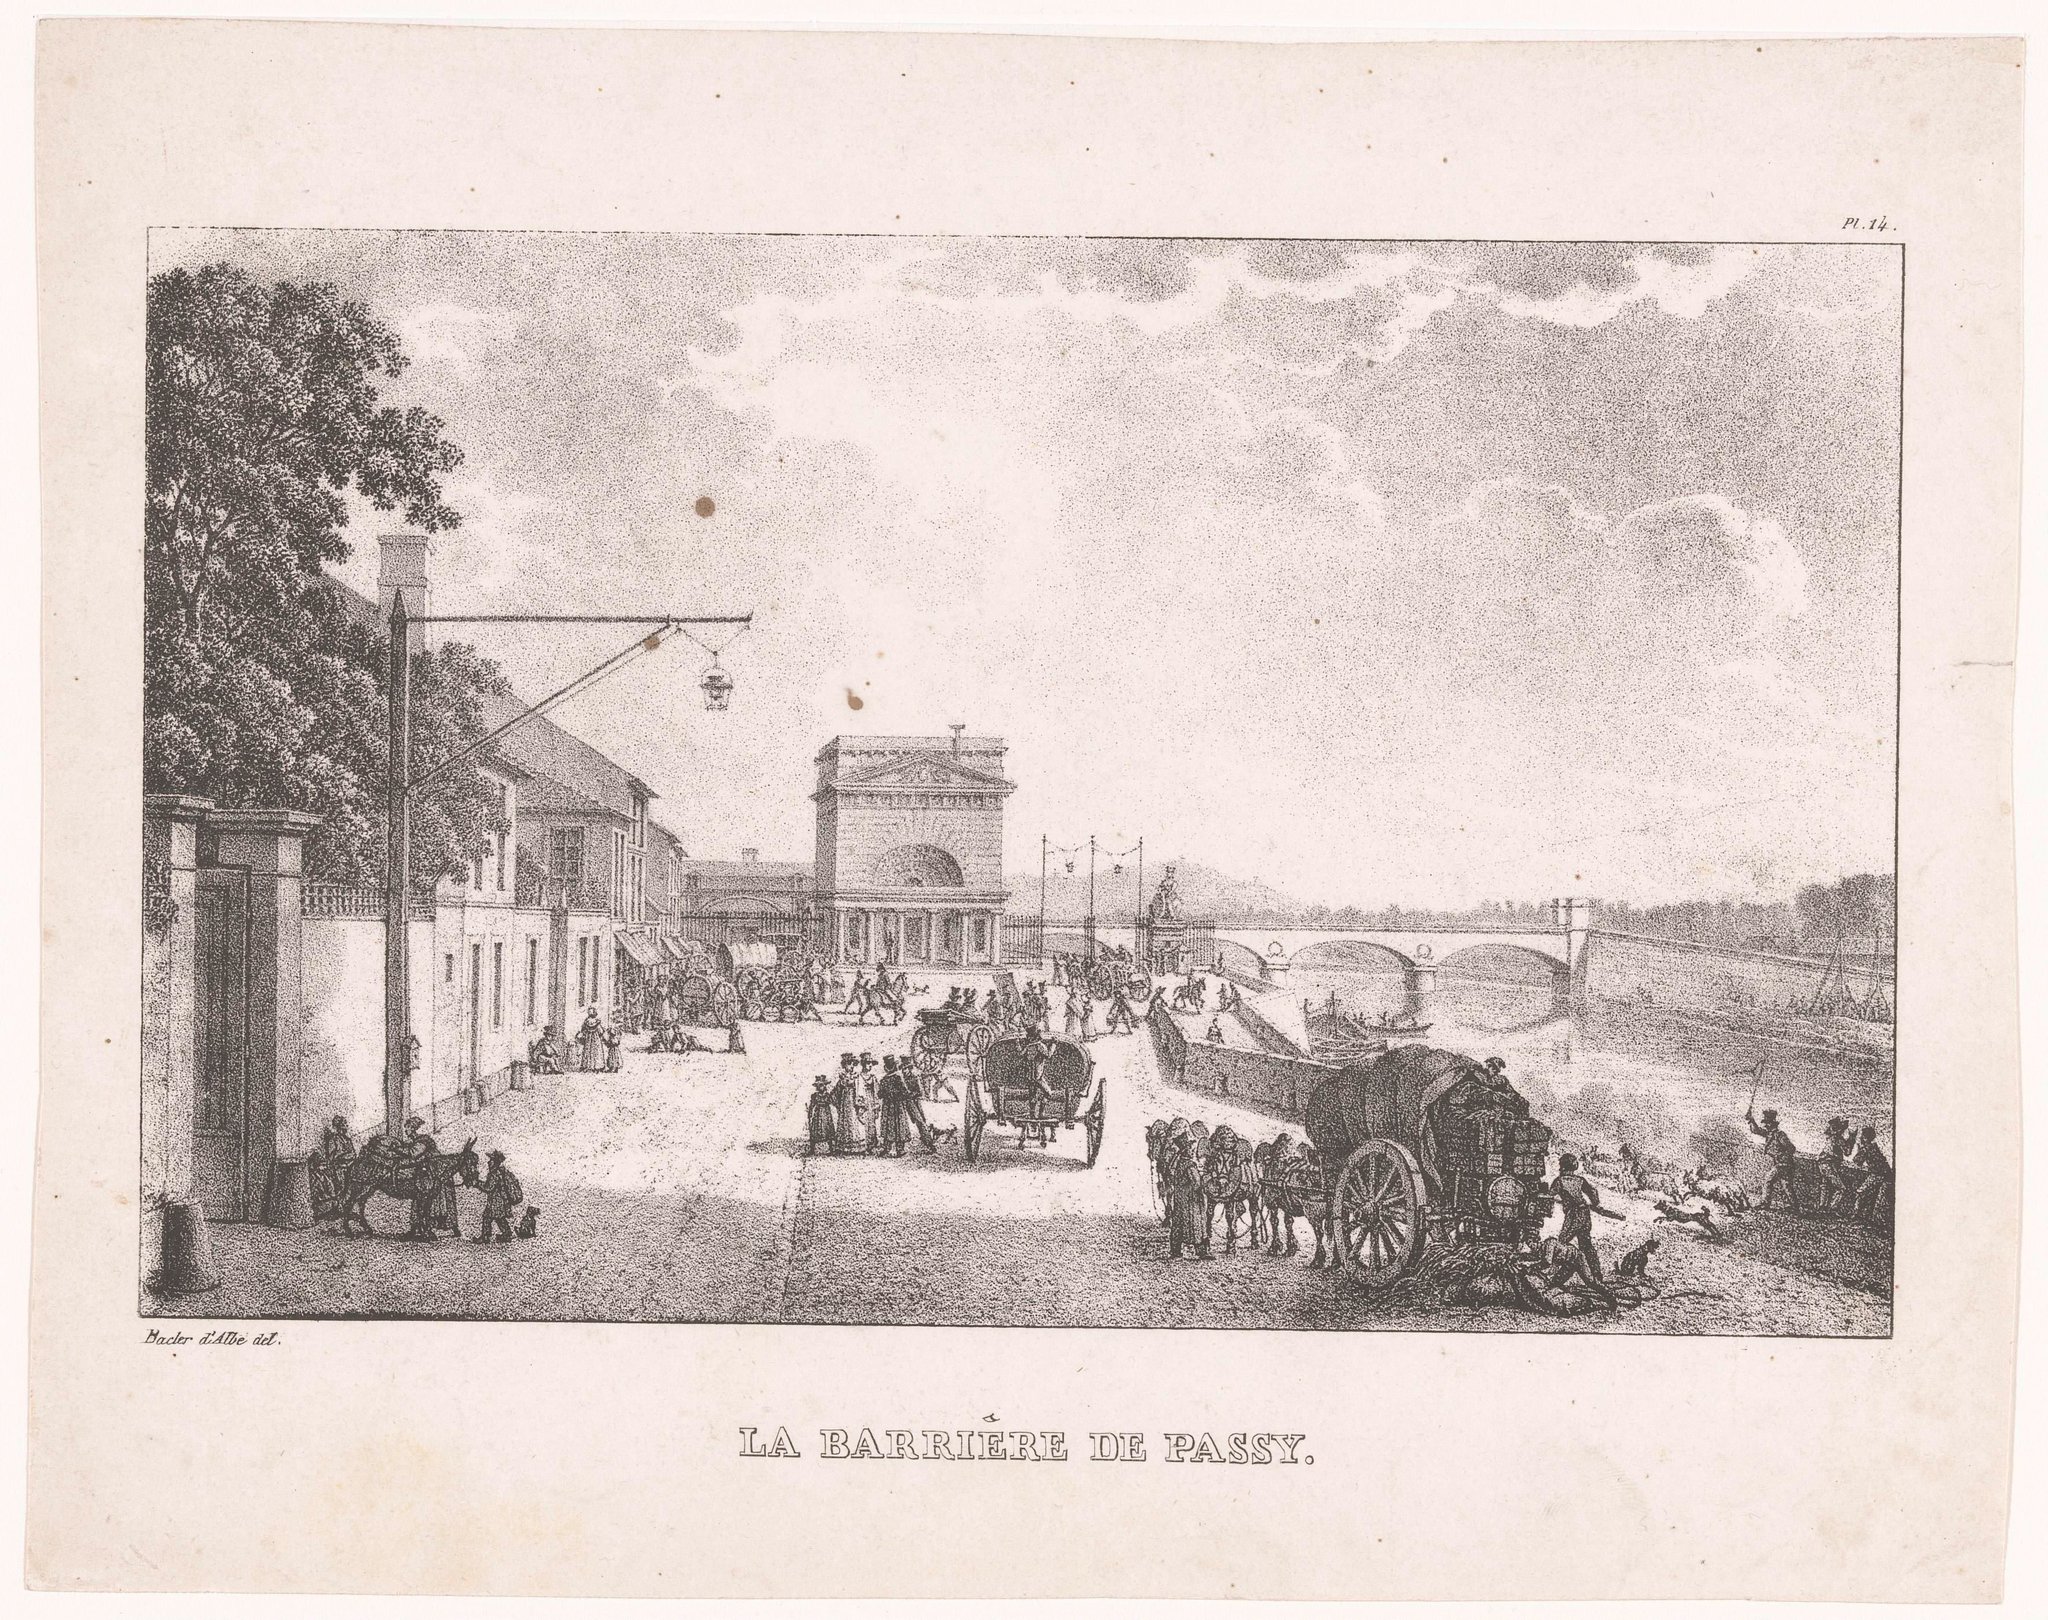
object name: print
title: Pittoreske gezichten op Parijs en omgeving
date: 1822-1824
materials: paper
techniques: lithograph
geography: paris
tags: bridge in city across river, canal, etc. (+ city(-scape) with figures, staffage), toll gate, (farm) wagon, freight wagon, cart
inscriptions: collector's mark: Lugt 2228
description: Op de voorgrond bevinden zich paarden en wagens, wandelaars en vee. Op de achtergrond het tolhuis met de tolpoort en de Pont d'Iéna.